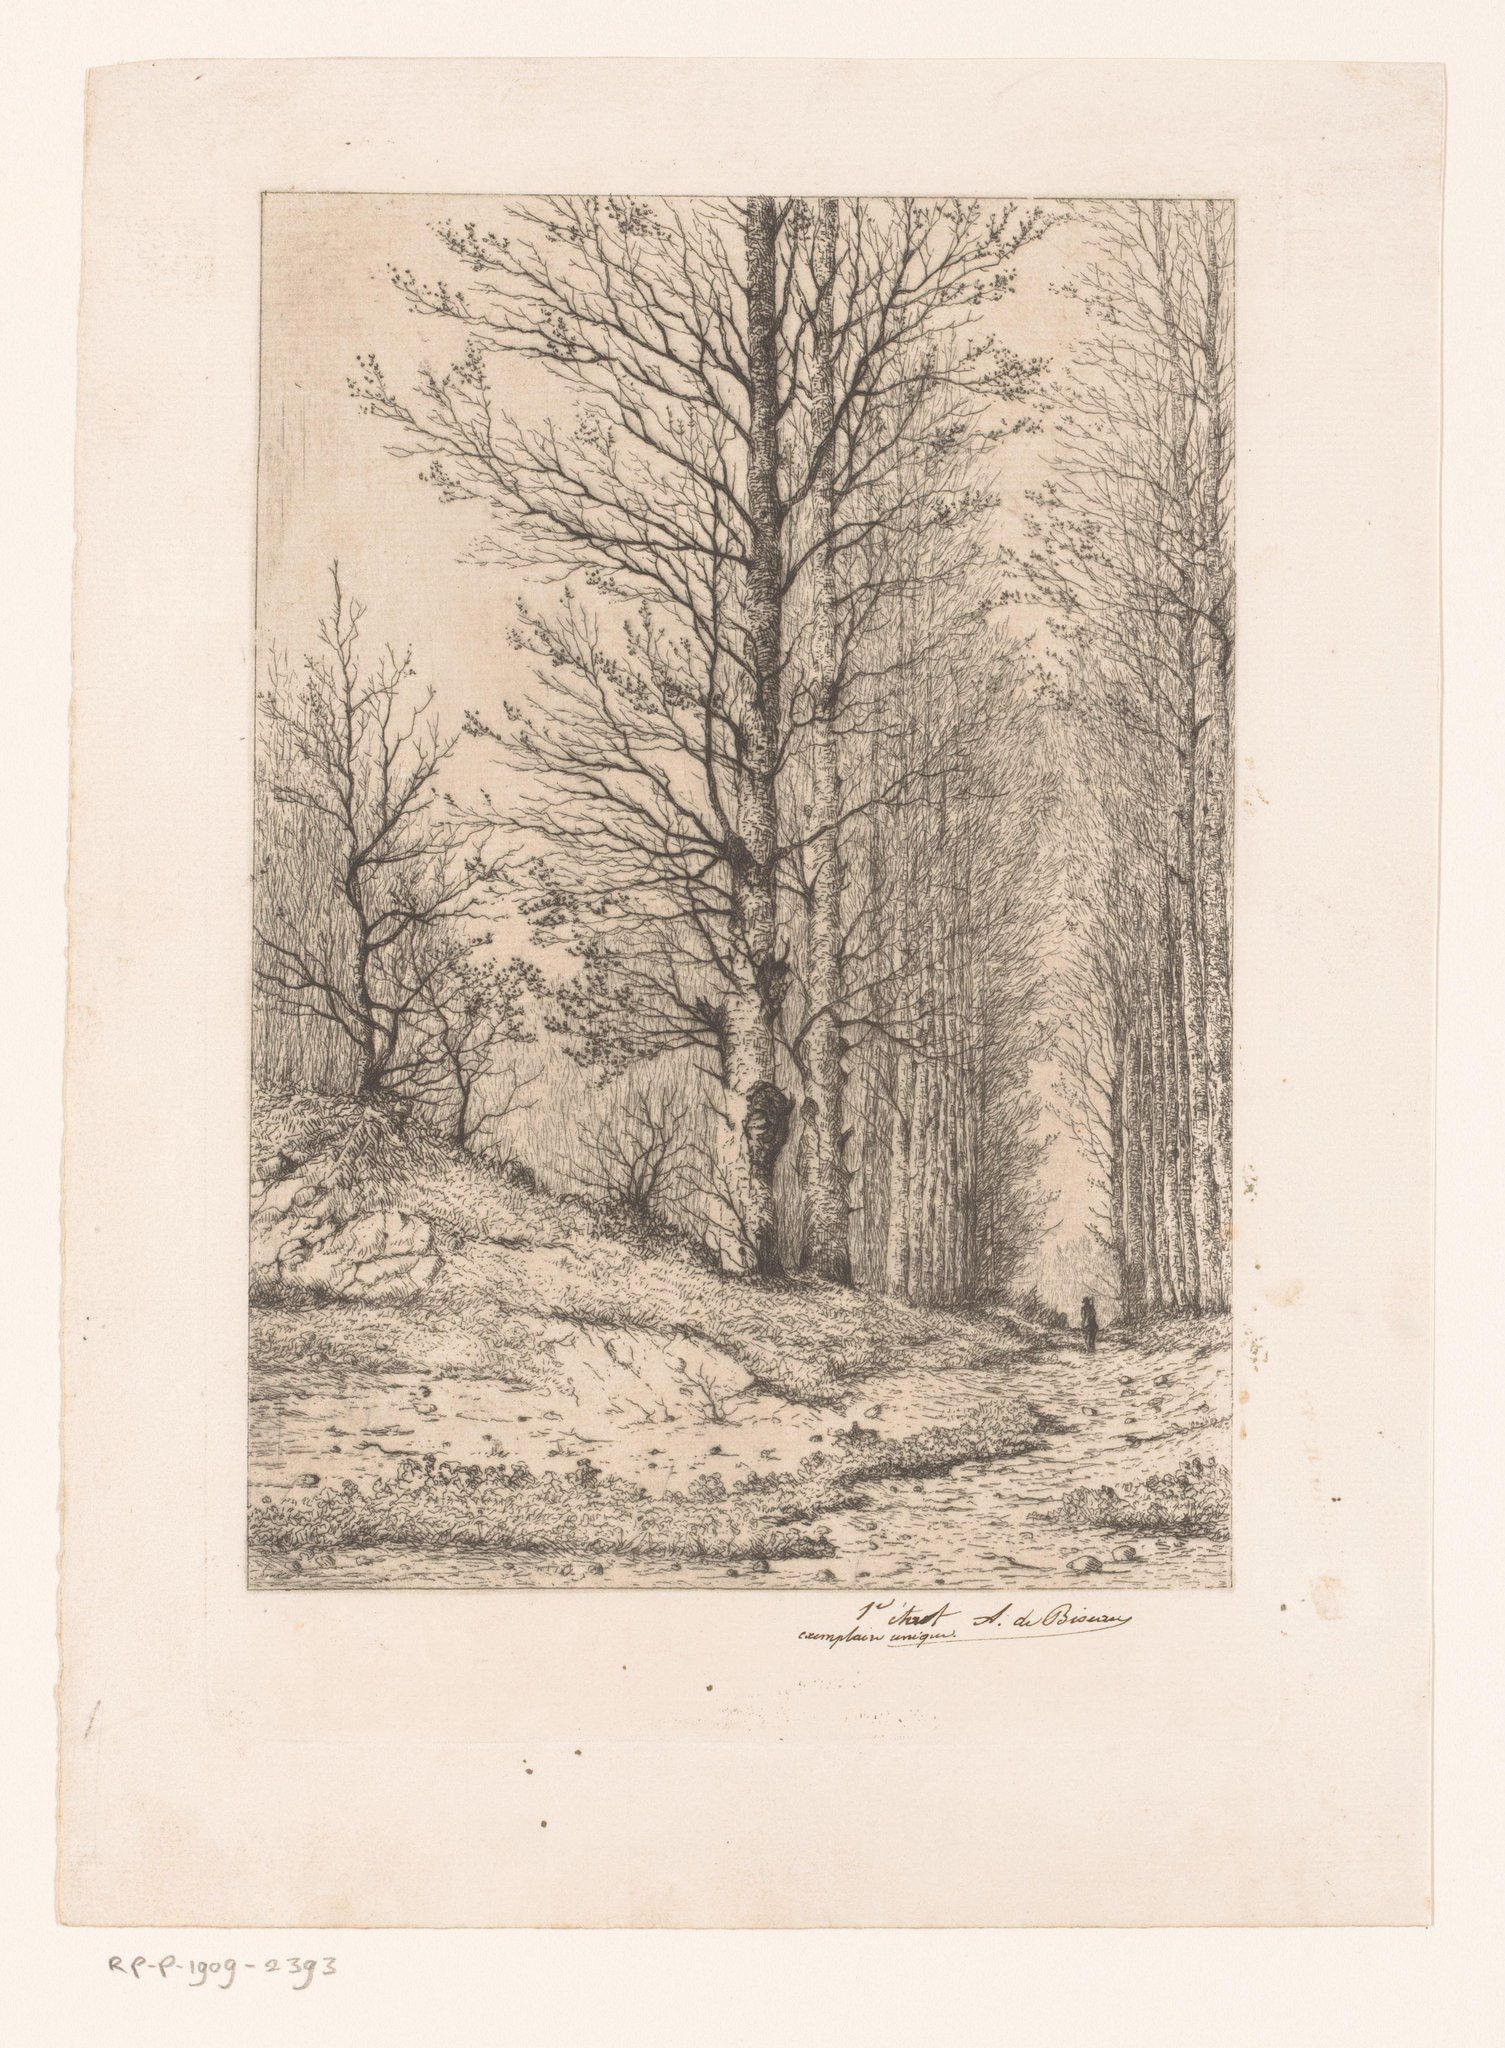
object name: print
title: Les dernières feuilles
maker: aristide de biseau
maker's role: print maker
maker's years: 1844-1883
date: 1873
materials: paper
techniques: etching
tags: horse throwing rider, trees: beech, forest path or lane, autumn, fall, 'autumnus'; 'autunno' (ripa)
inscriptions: collector's mark: Lugt 2228, inscription: ‘1e etat exemplaire uniques’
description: Een latere staat van deze prent is gebruikt in: Album du Journal des Beaux-Arts. Antwerpen, s.n., 1873.